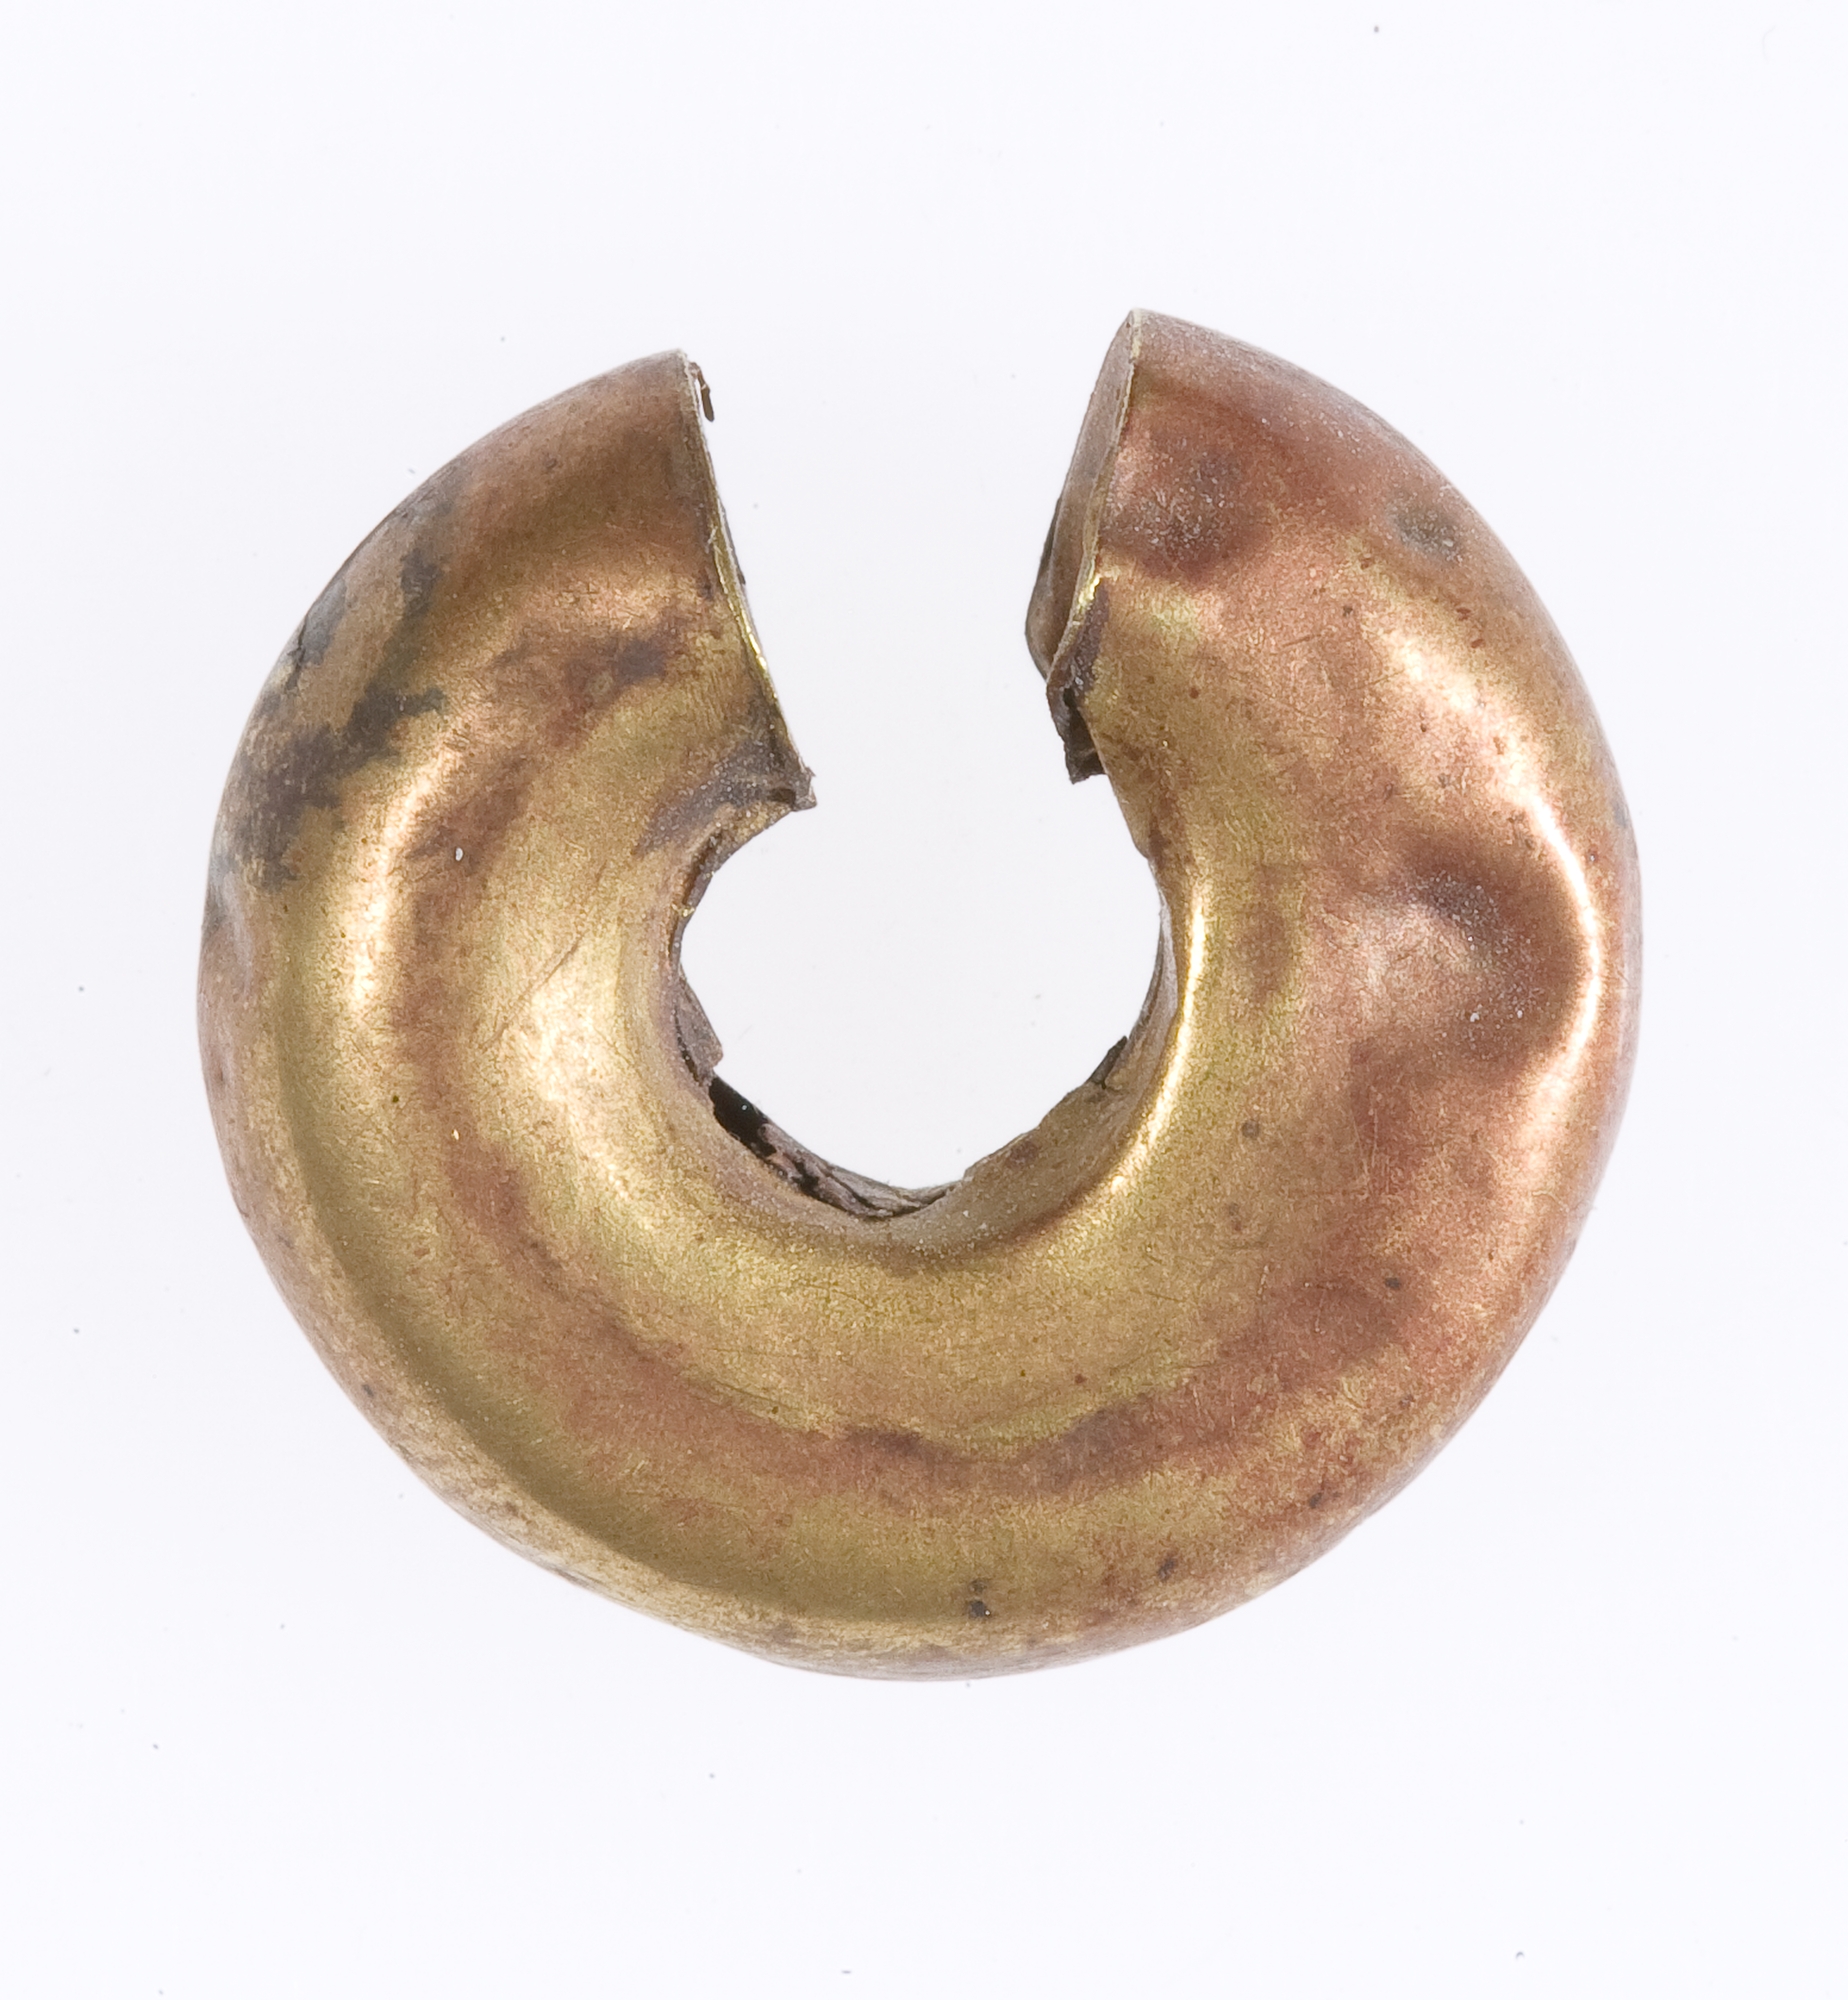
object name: earring, penannular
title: Penannular Earring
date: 1550-1425 BCE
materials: gold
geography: egypt